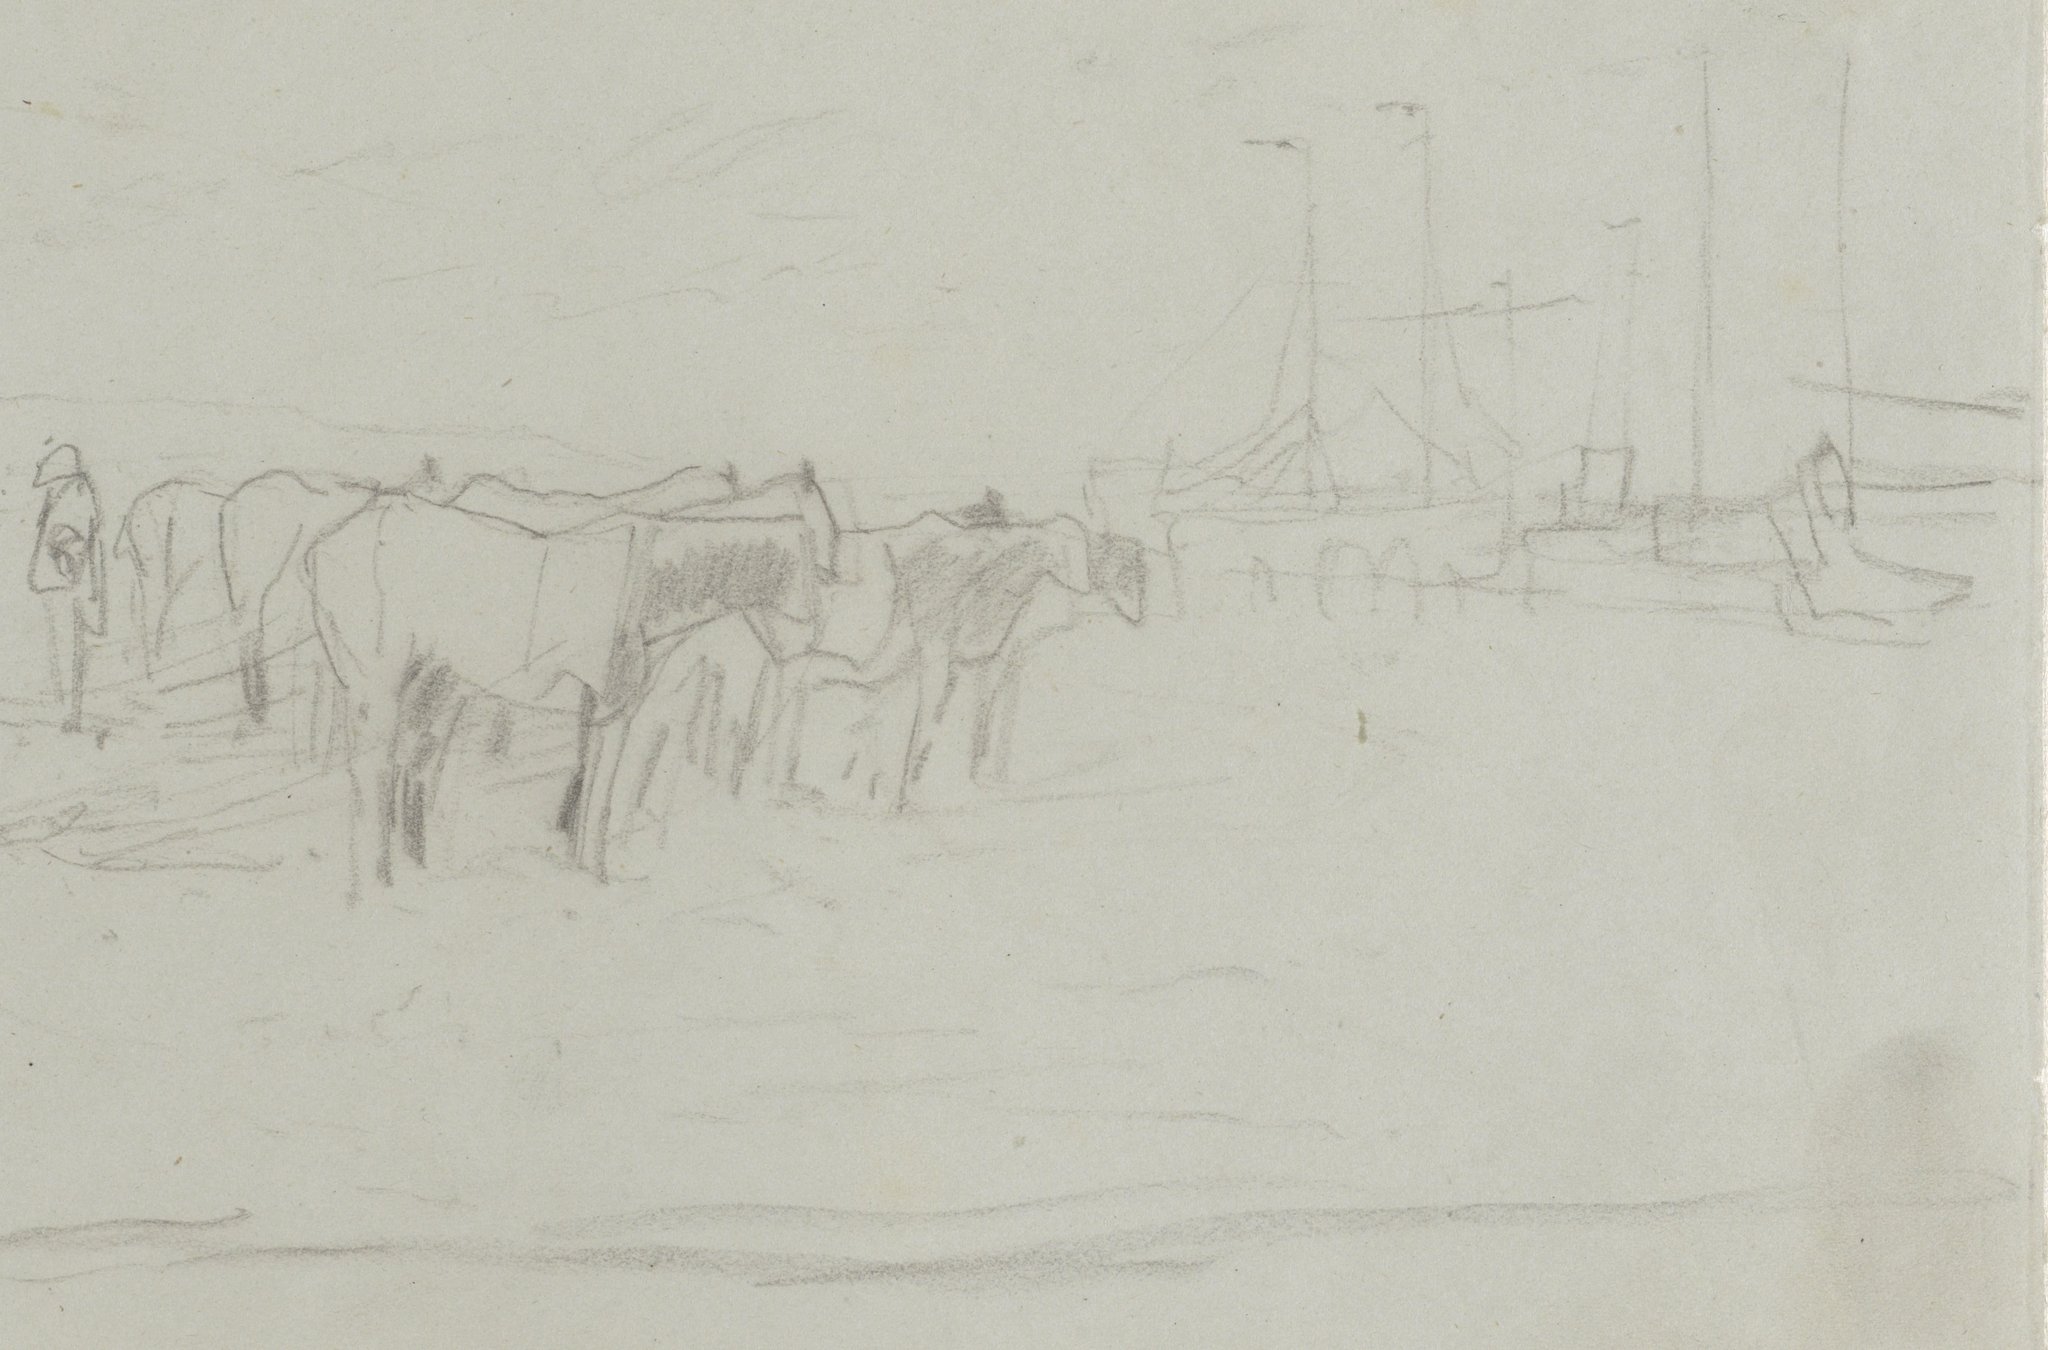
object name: drawing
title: Strand met paarden en schuiten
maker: anton mauve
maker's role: draughtsman, painter, print maker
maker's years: 1838-1888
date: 1848-1888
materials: chalk, paper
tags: sailing-ship, sailing-boat, horse, beach